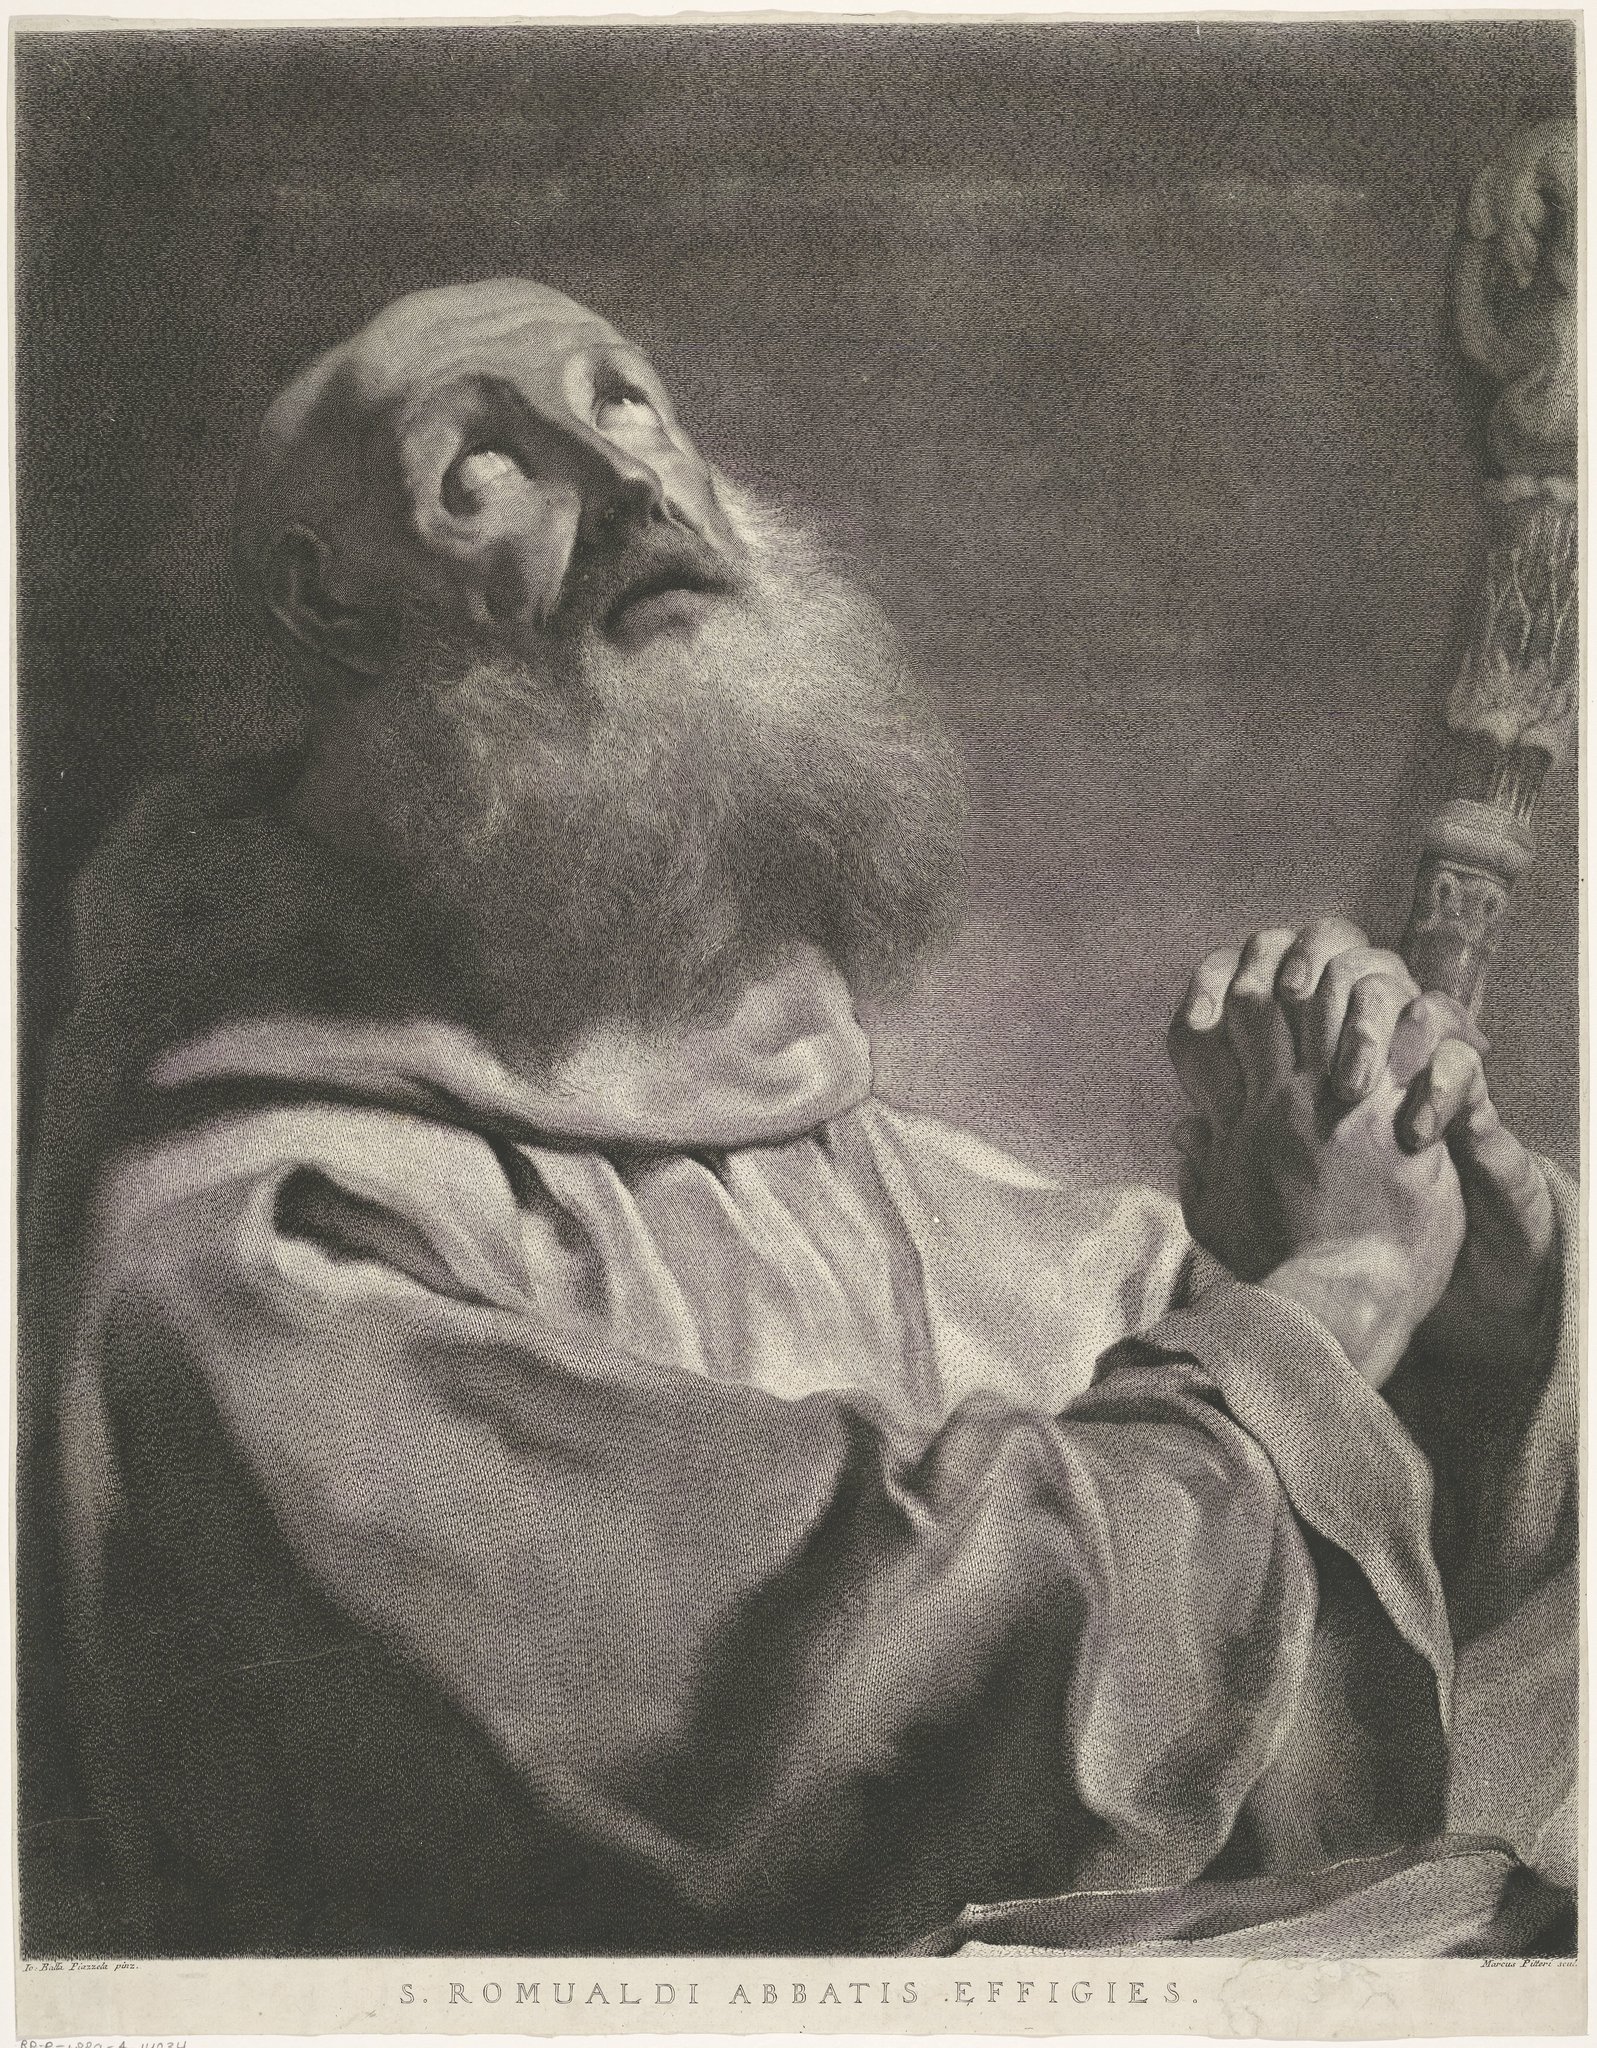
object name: print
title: De heilige Romualdus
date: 1712-1786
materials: paper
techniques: engraving, etching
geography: venice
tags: the benedictine monk romuald of camaldoli (or ravenna), founder of the camaldolese order; possible attributes: book, t-shaped staff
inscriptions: collector's mark: Lugt 2228